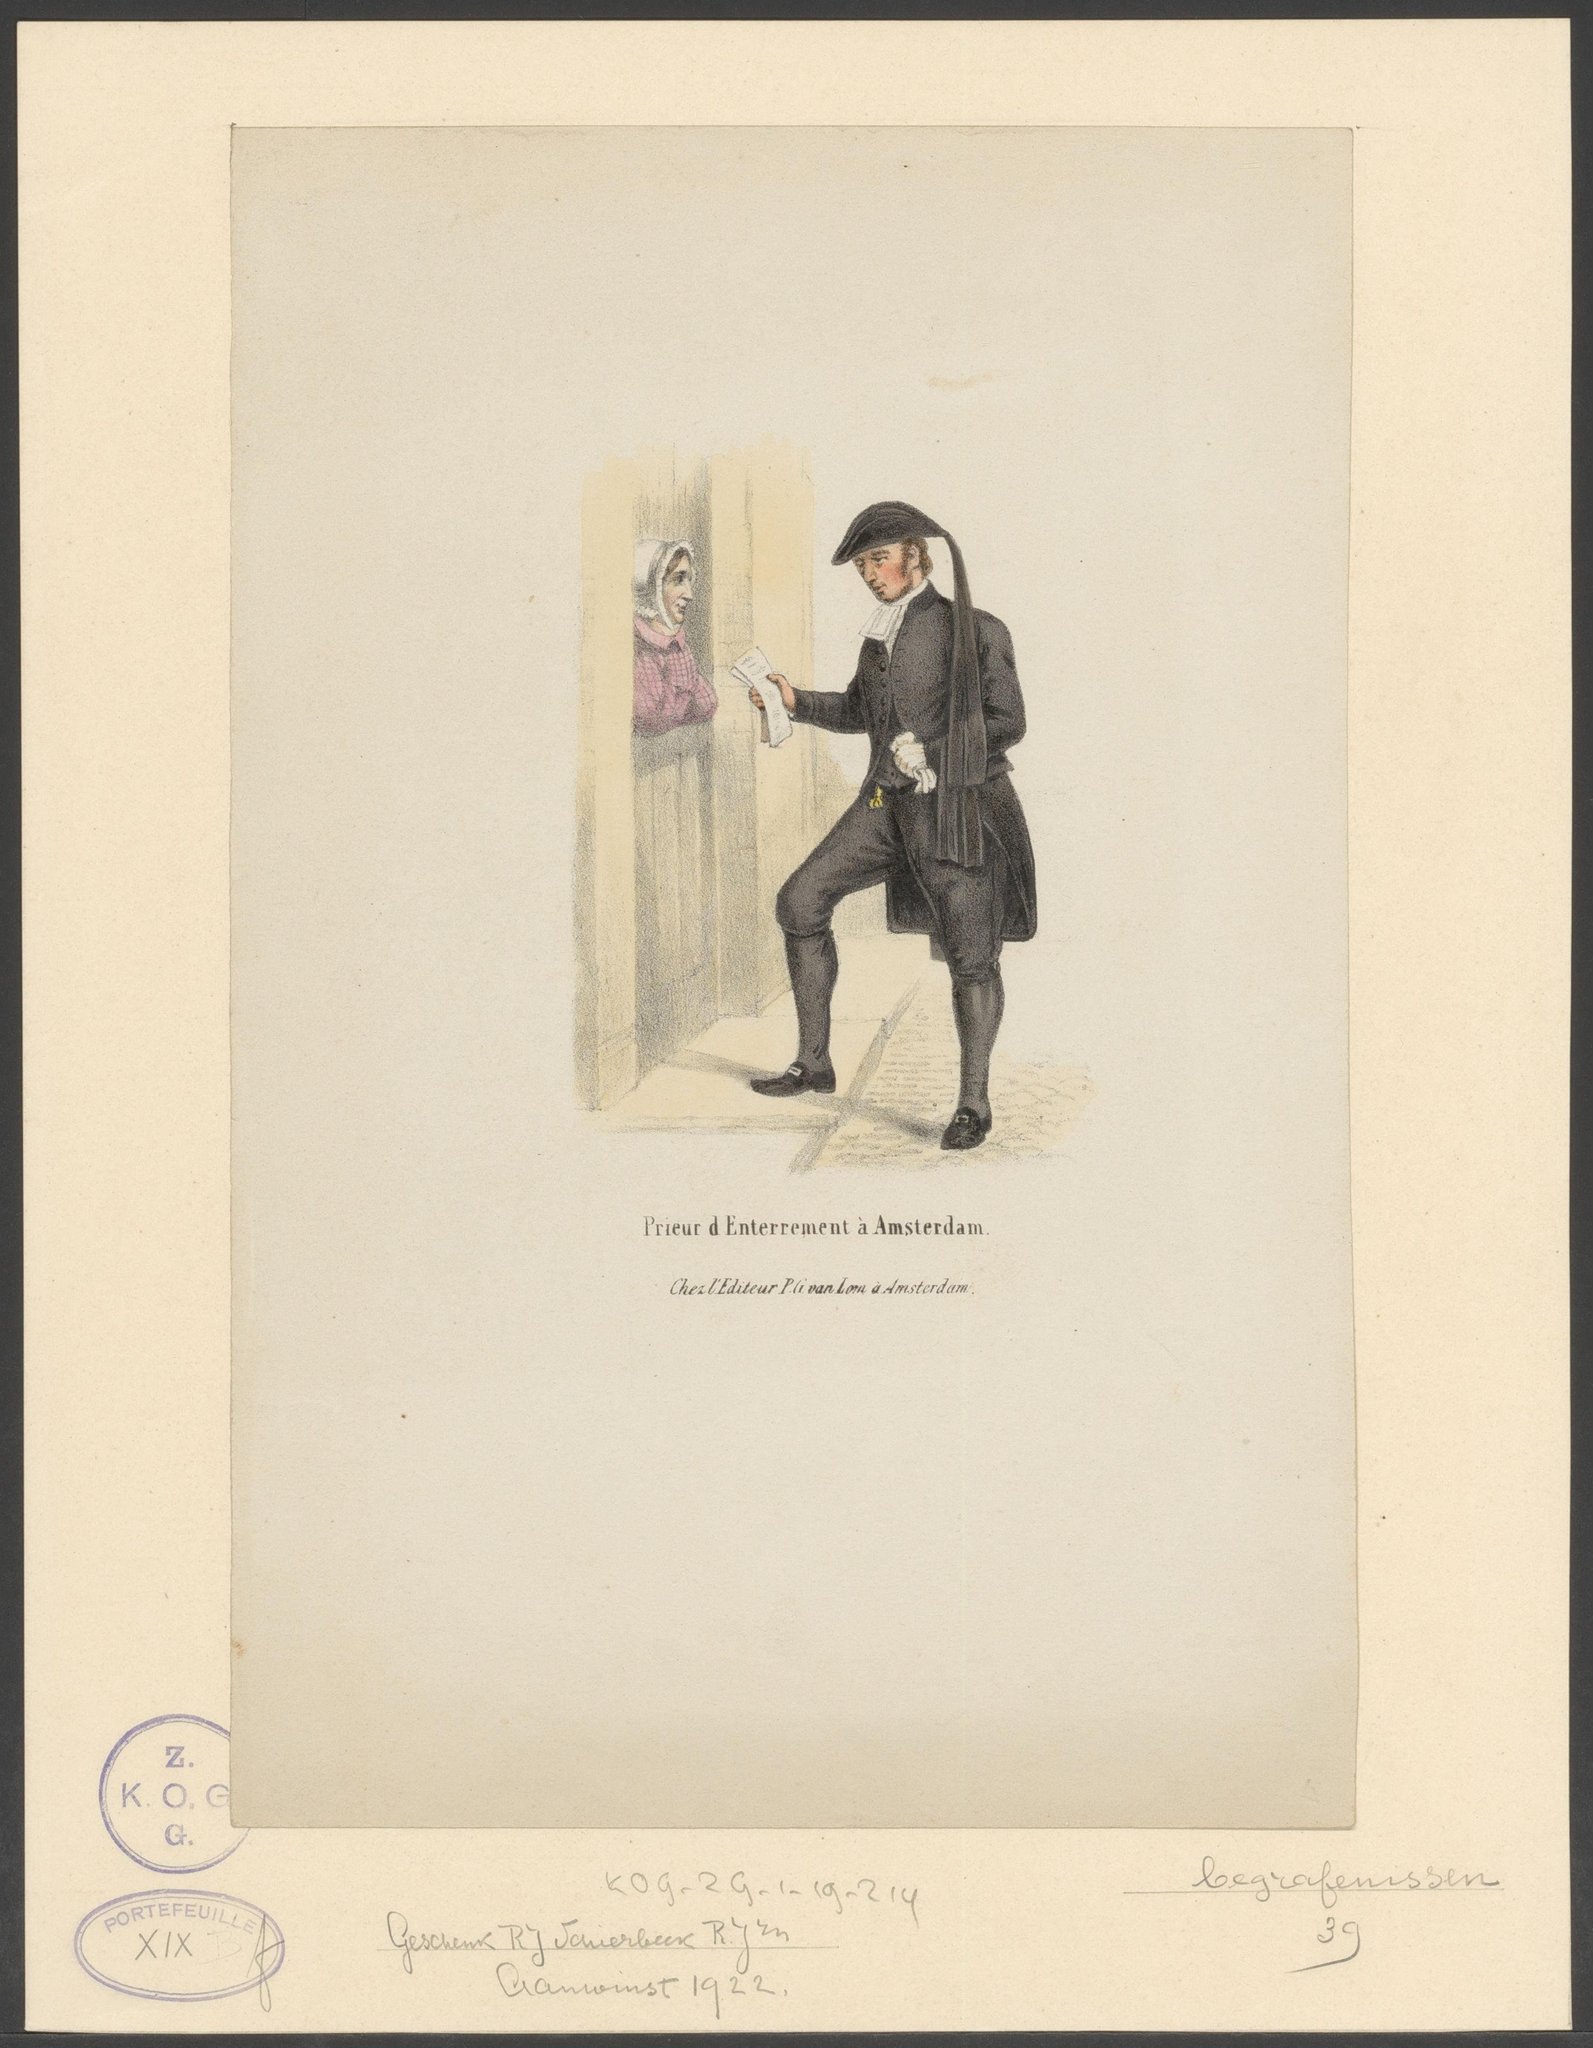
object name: print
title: Prieur d'Enterrement à Amsterdam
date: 1850-1870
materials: paper, watercolor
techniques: hand coloring, lithograph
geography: netherlands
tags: oral announcement (of death), undertaker's man, clothes, costume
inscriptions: collector's mark: Lugt 1641, collector's mark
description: Een Amsterdamse aanspreker leest het bericht voor over het overlijden van iemand. Staande bij een halve deur waarachter een vrouw staat. Hij draagt een hoed met afhangend rouwlint aan de achterzijde. Onderwerpsrubrieken binnen de Atlas Zeden en Gewoonten: Des Menschen Begin, Midden en Einde. Begrafenissen, aansprekers, doodgravers, enz.